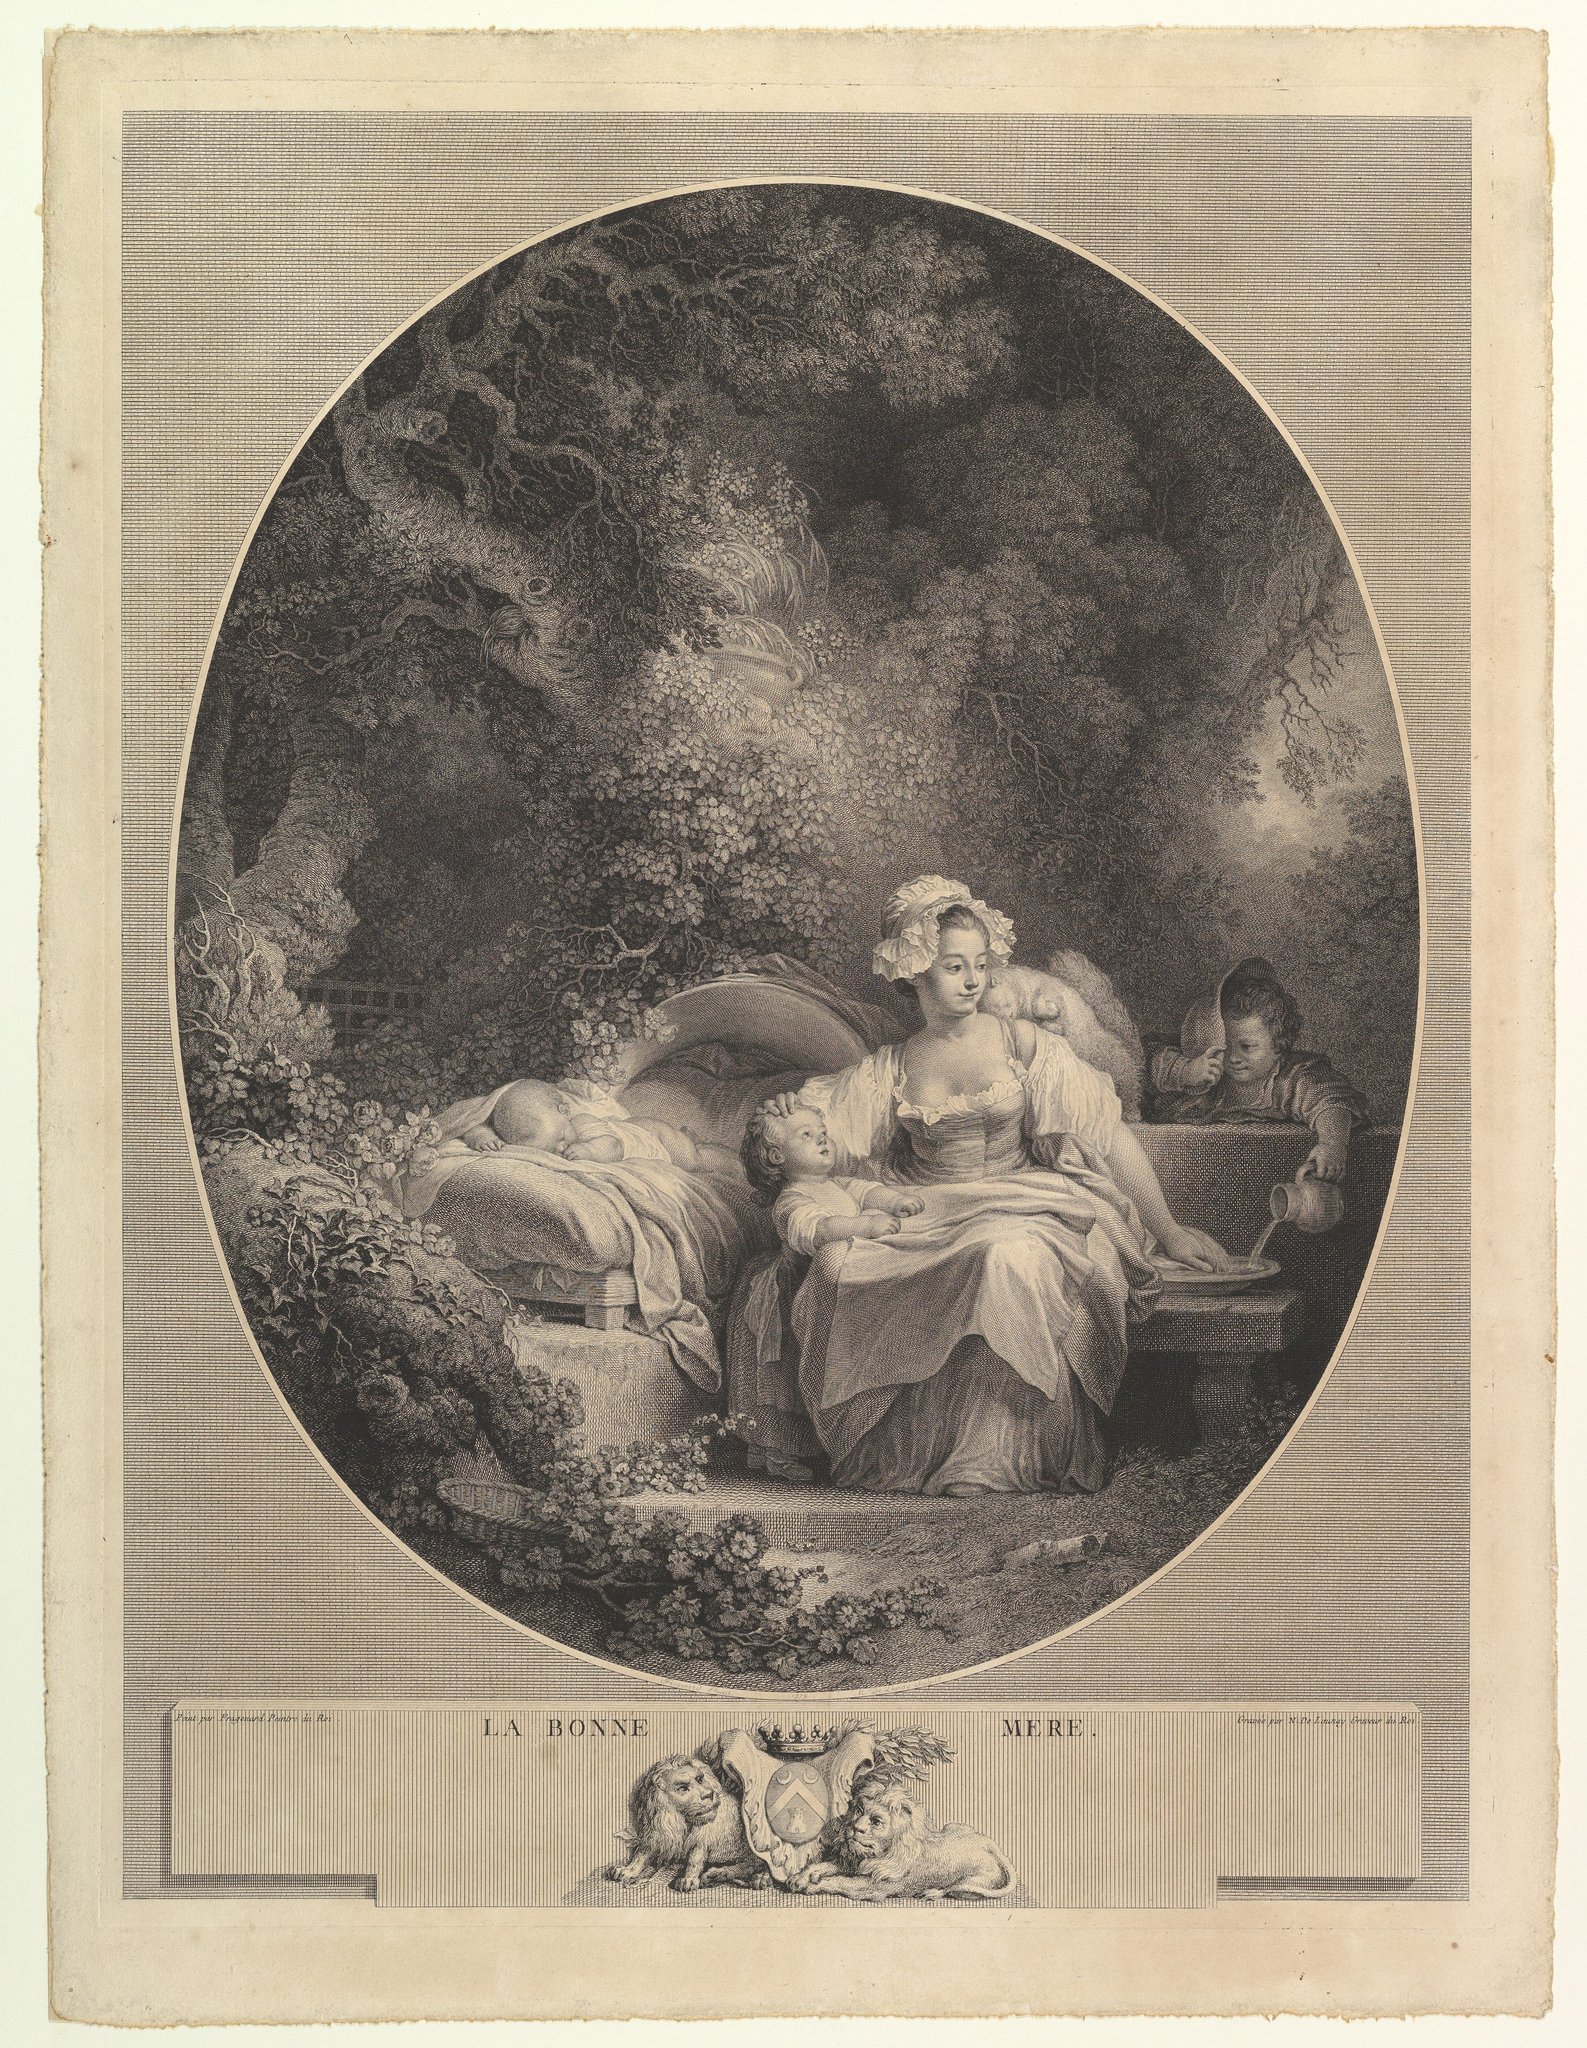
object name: print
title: La Bonne Mere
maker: jean honoré fragonard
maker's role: artist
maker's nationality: french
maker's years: 1732-1806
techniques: etching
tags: infants,mothers,trees,coat of arms